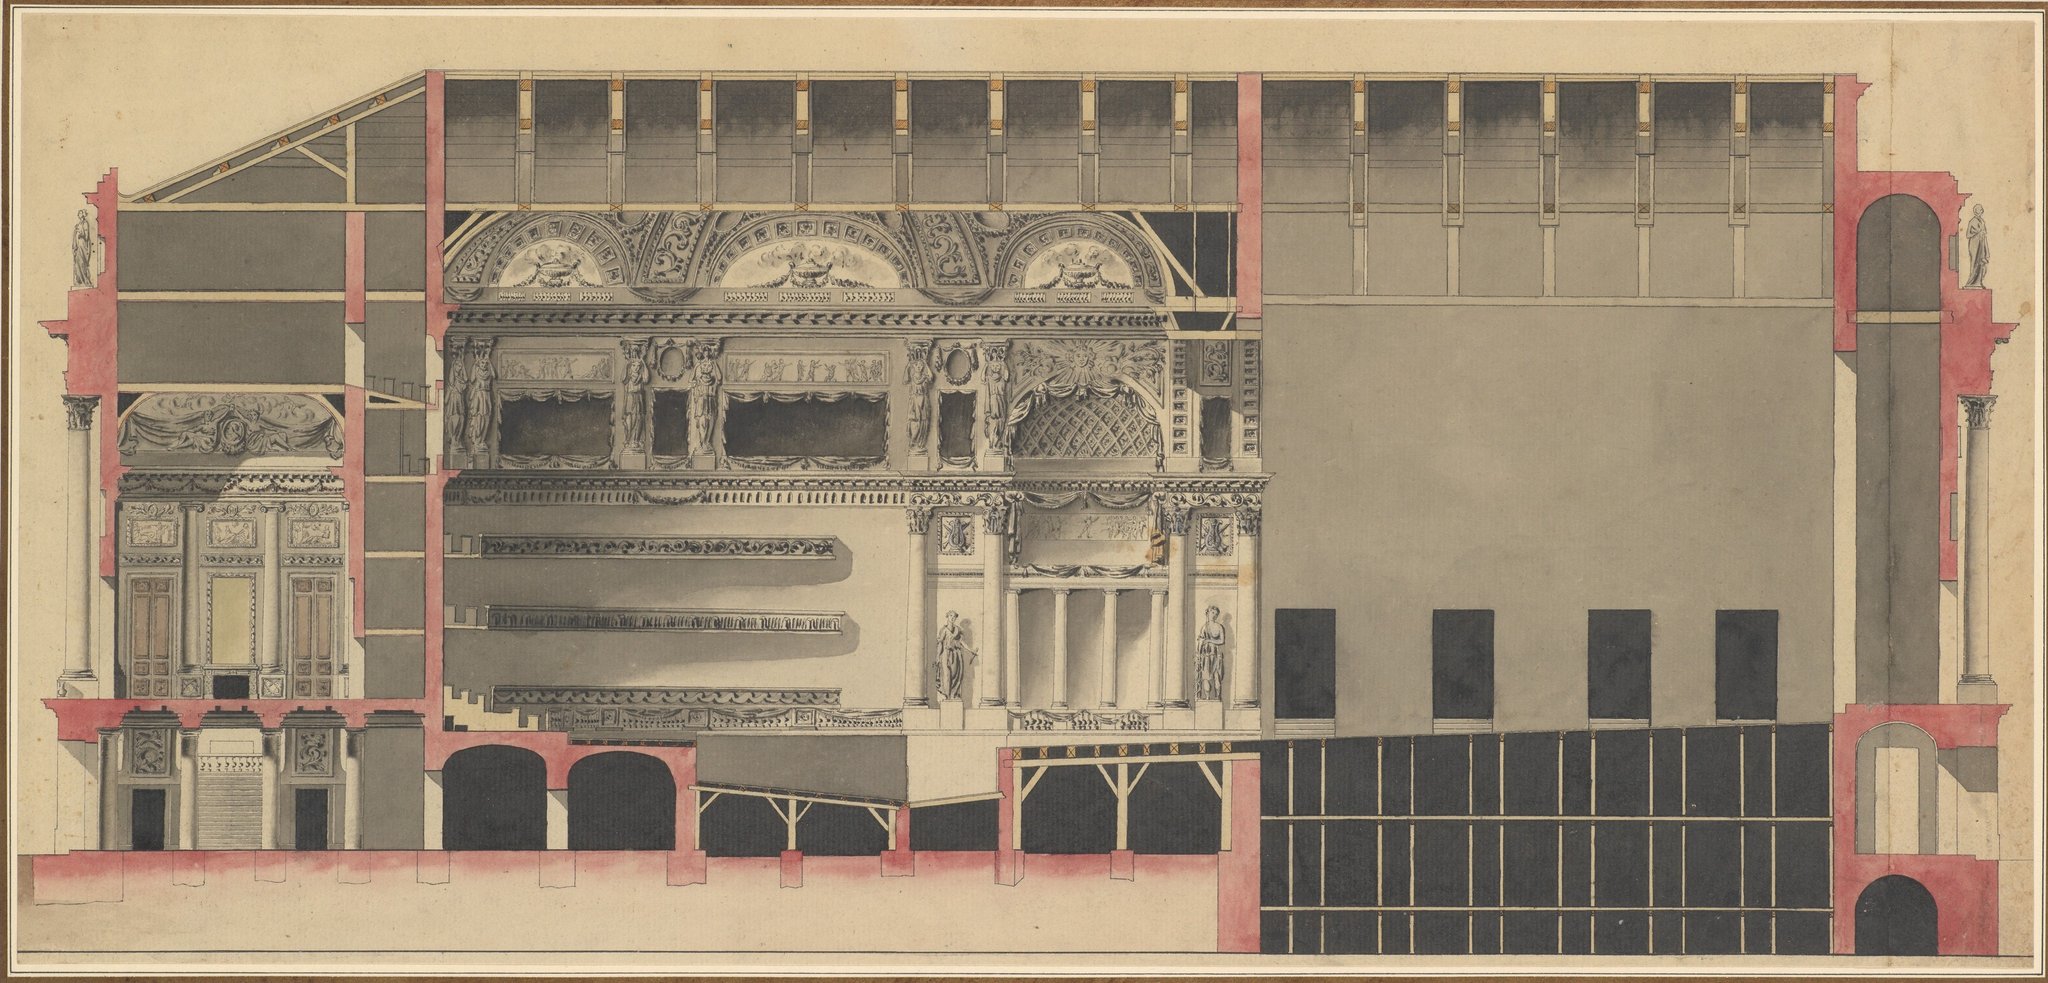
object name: drawing ornament architecture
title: Longitudinal Section of a Theatre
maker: nicolas marie potain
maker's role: artist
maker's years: 1713-1796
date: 1701-1800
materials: ink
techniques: brush, pen, wash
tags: theatre,architecture